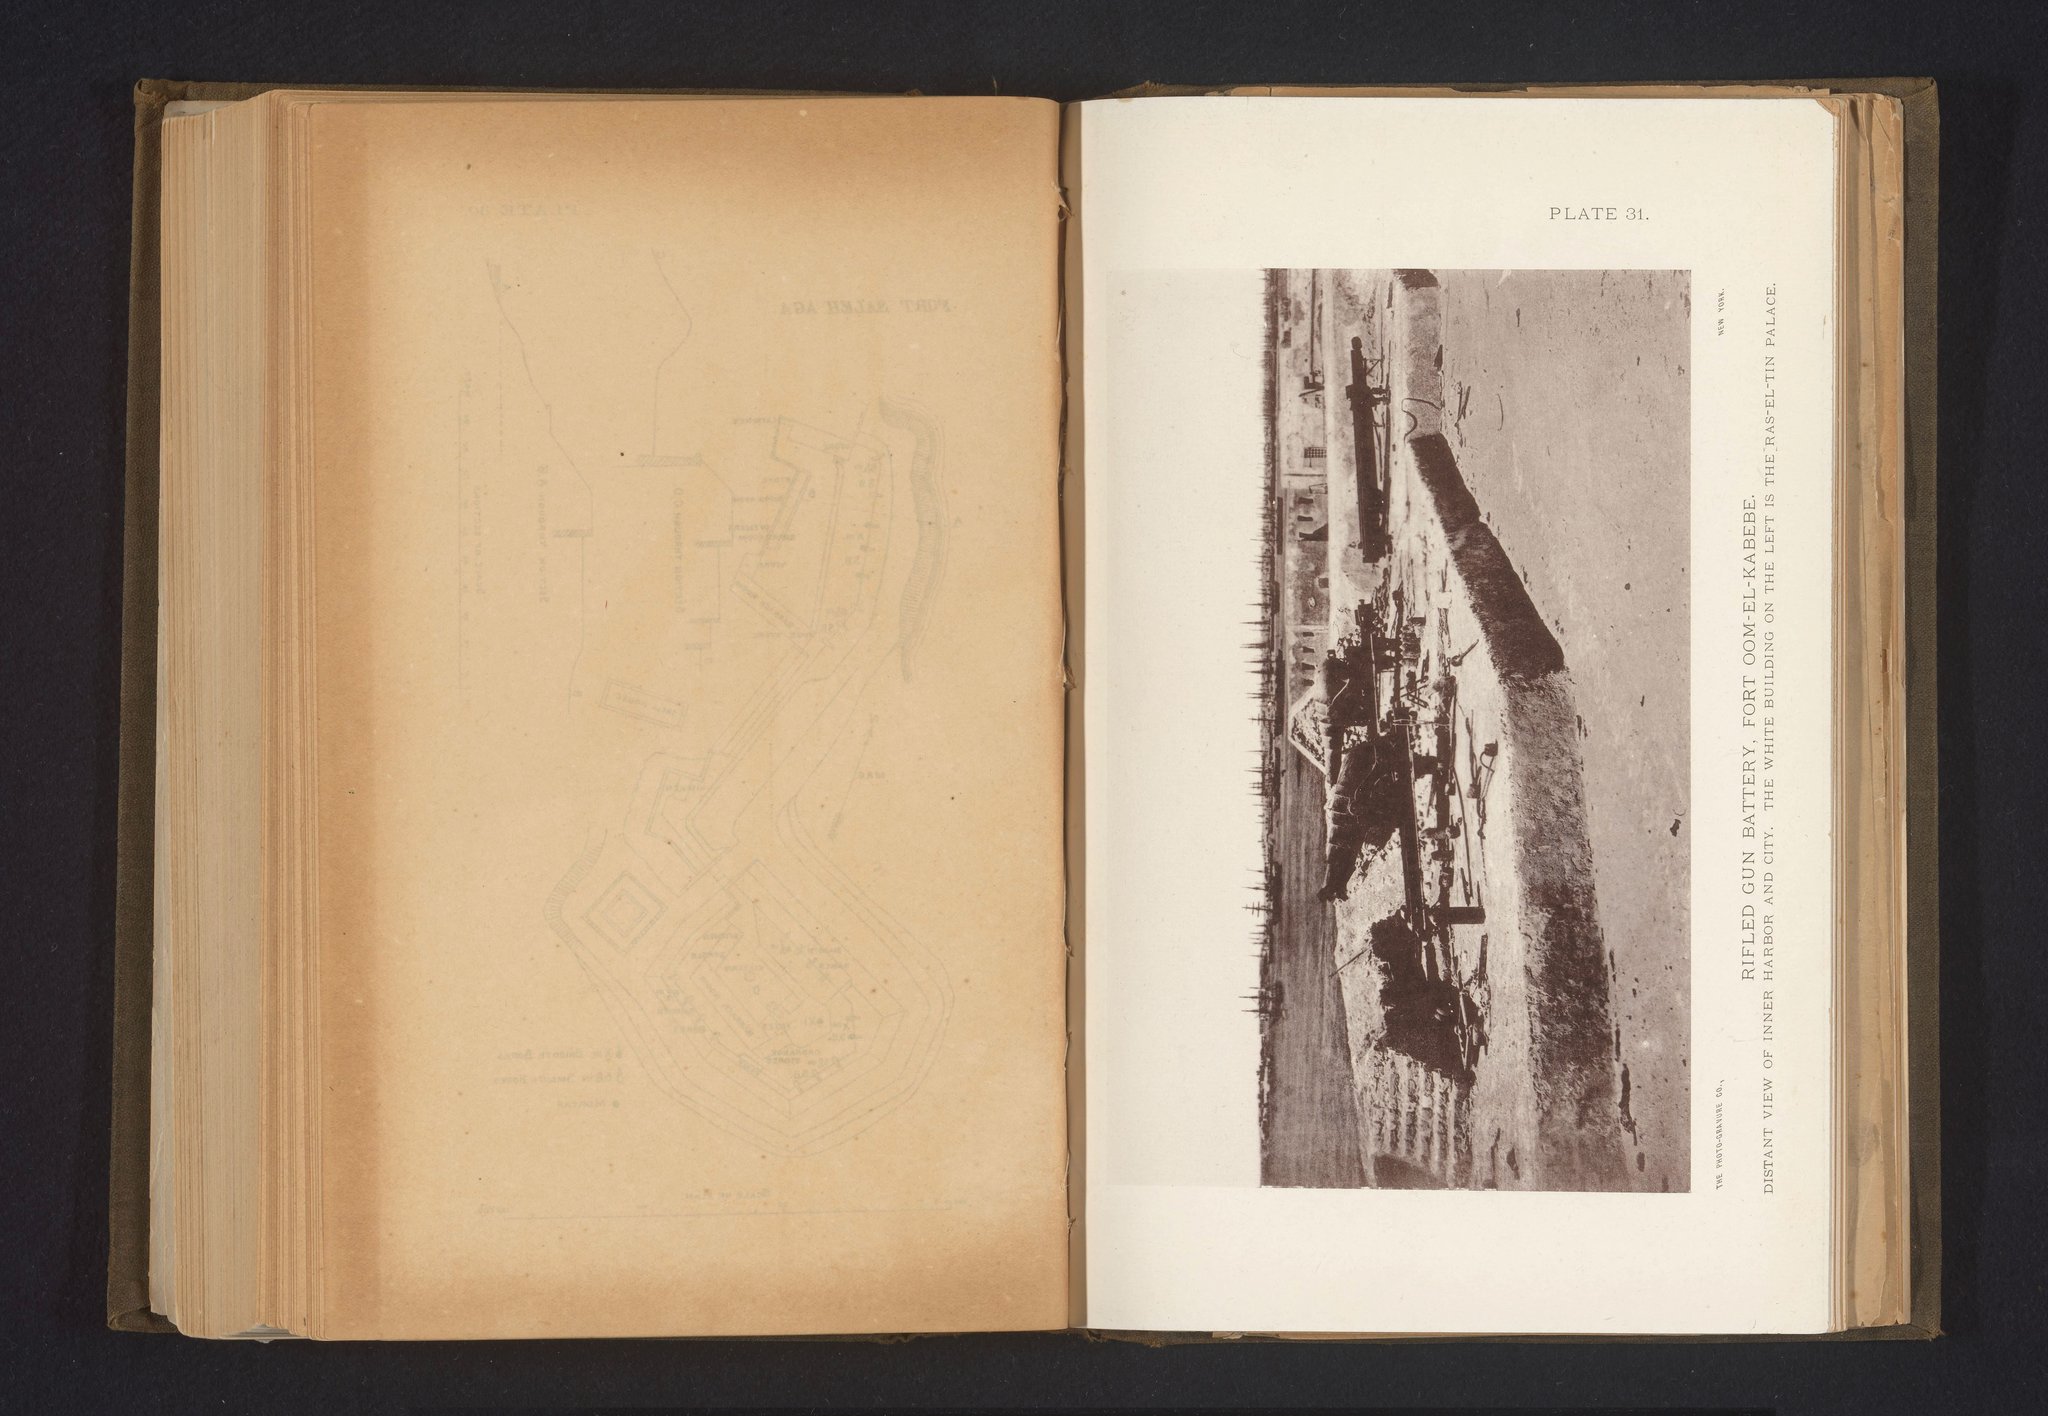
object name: page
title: Gezicht op kanonnen op fort Omuk Kebebe in Alexandrië en een binnenhaven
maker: Anonymous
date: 1882-1885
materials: paper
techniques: photograph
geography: new york city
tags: harbour, fortress, firearms: cannon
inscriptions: number: ‘Plate 31.’